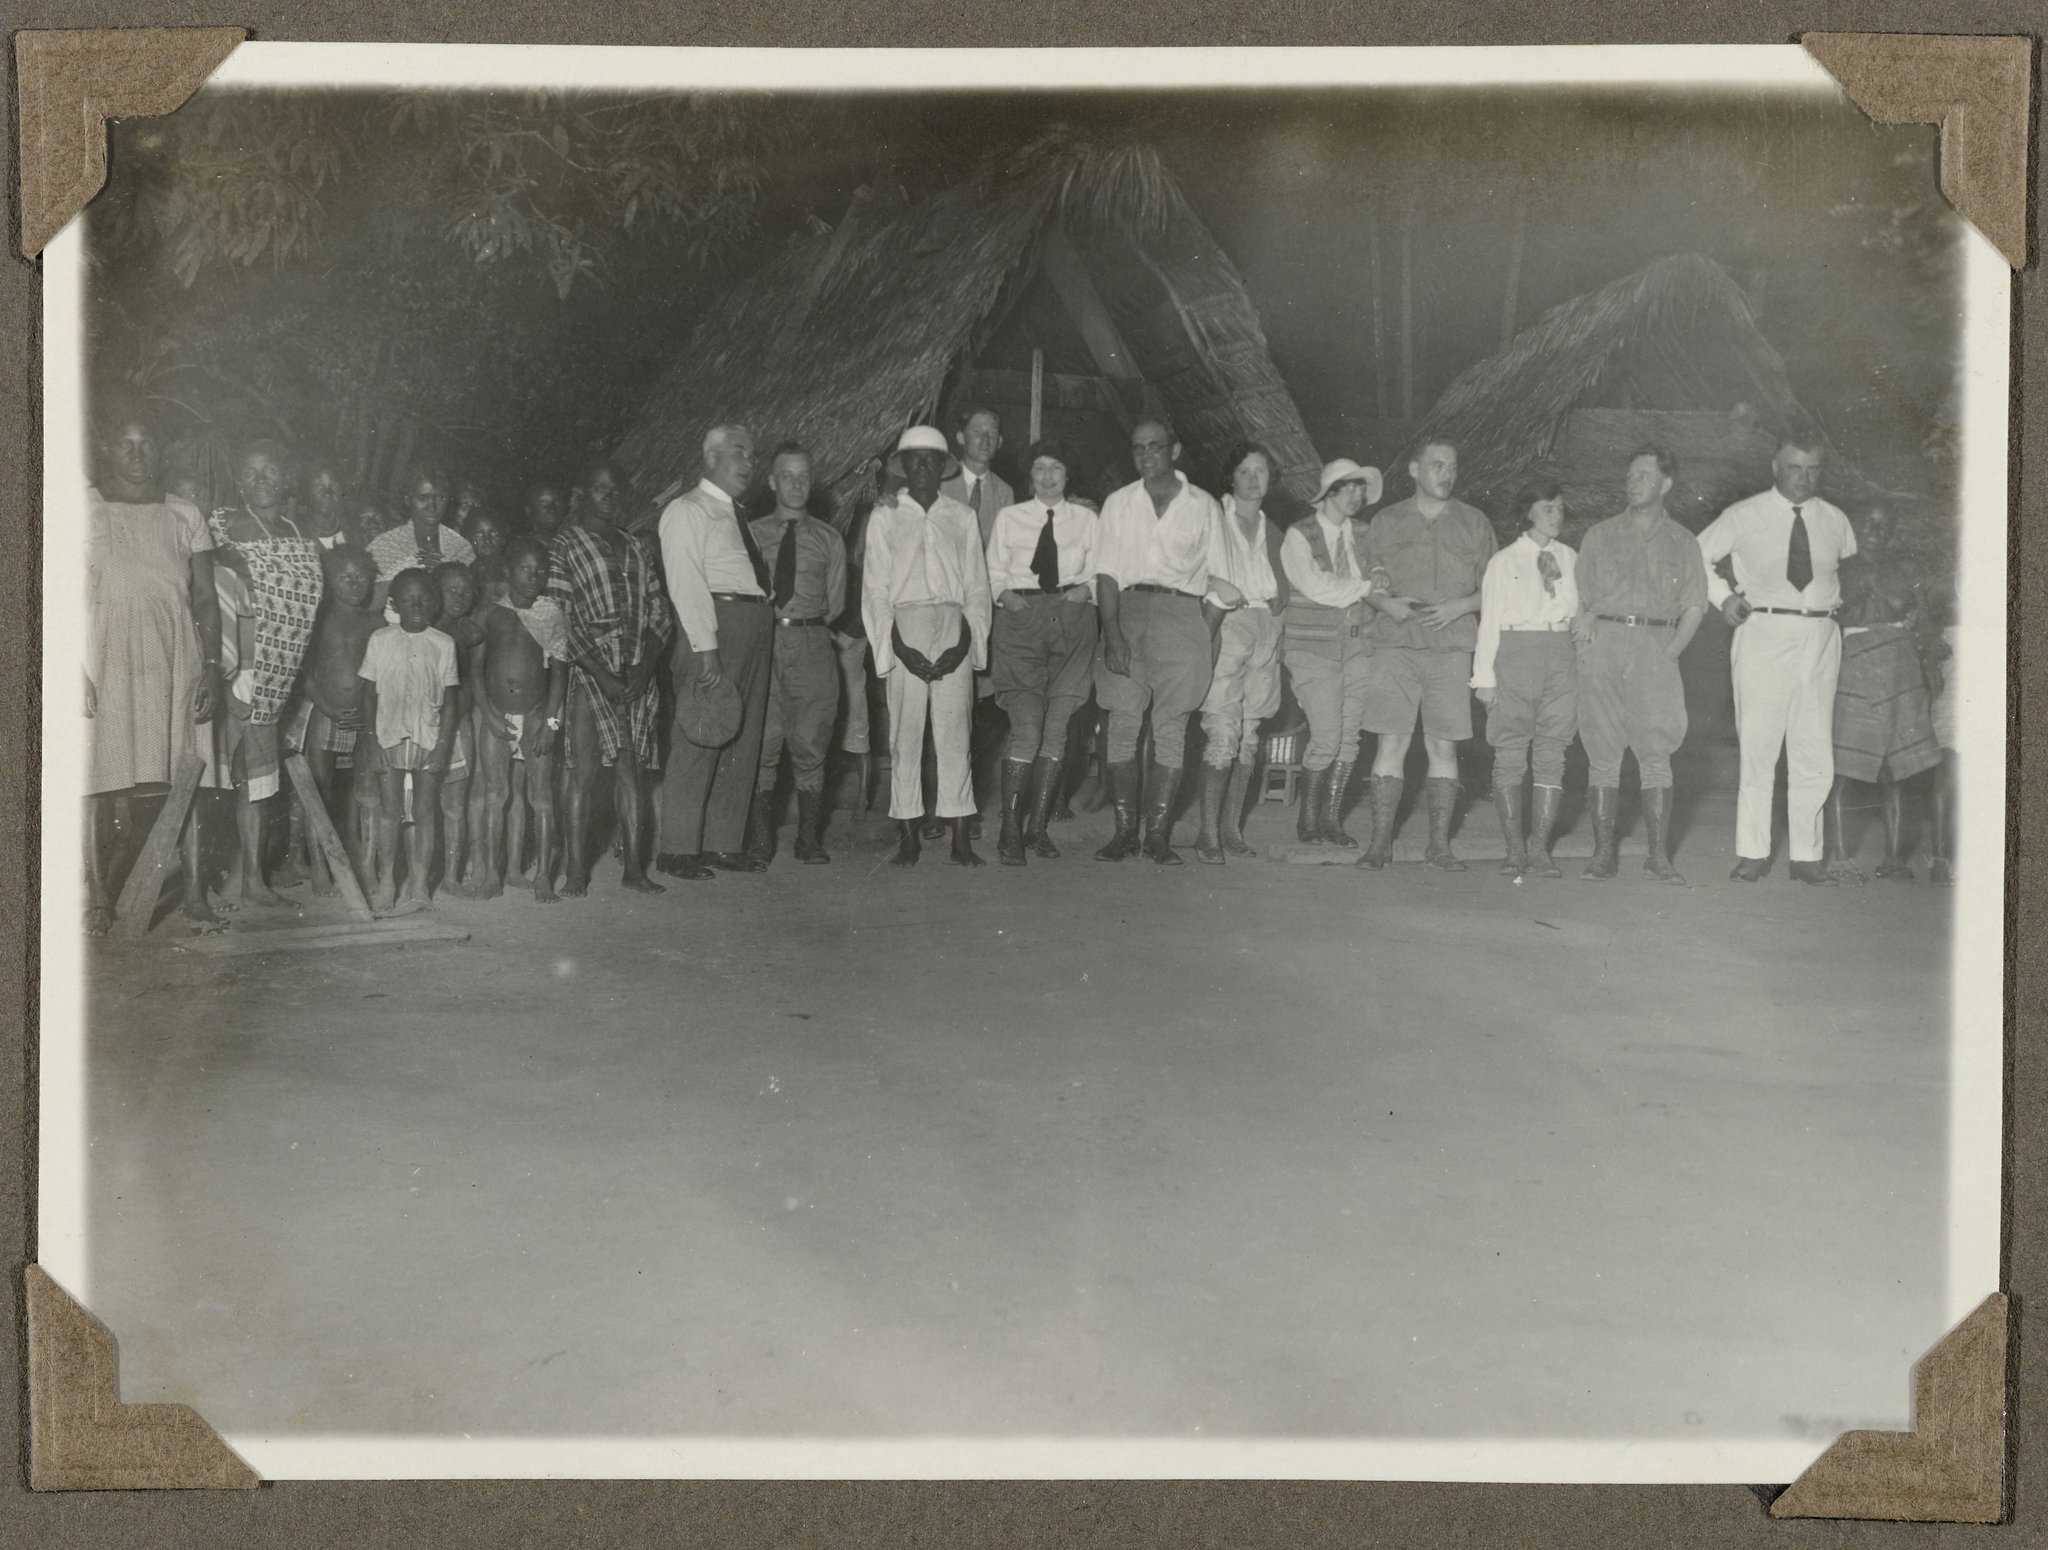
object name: photograph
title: Groep Nederlanders op bezoek in een dorp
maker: Anonymous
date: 1925-1927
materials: photographic support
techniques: photography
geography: suriname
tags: anonymous historical persons portrayed in a group, in a group-portrait, suriname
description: Groep Nederlanders waaronder het echtpaar Jetten op bezoek in een dorp van Marrons. Foto met hoekjes bevestigd op een bladzijde van een albumblad in het fotoalbum over de familie Jetten en het leven en werken in de mijnstad Moengo in Suriname rond 1927.